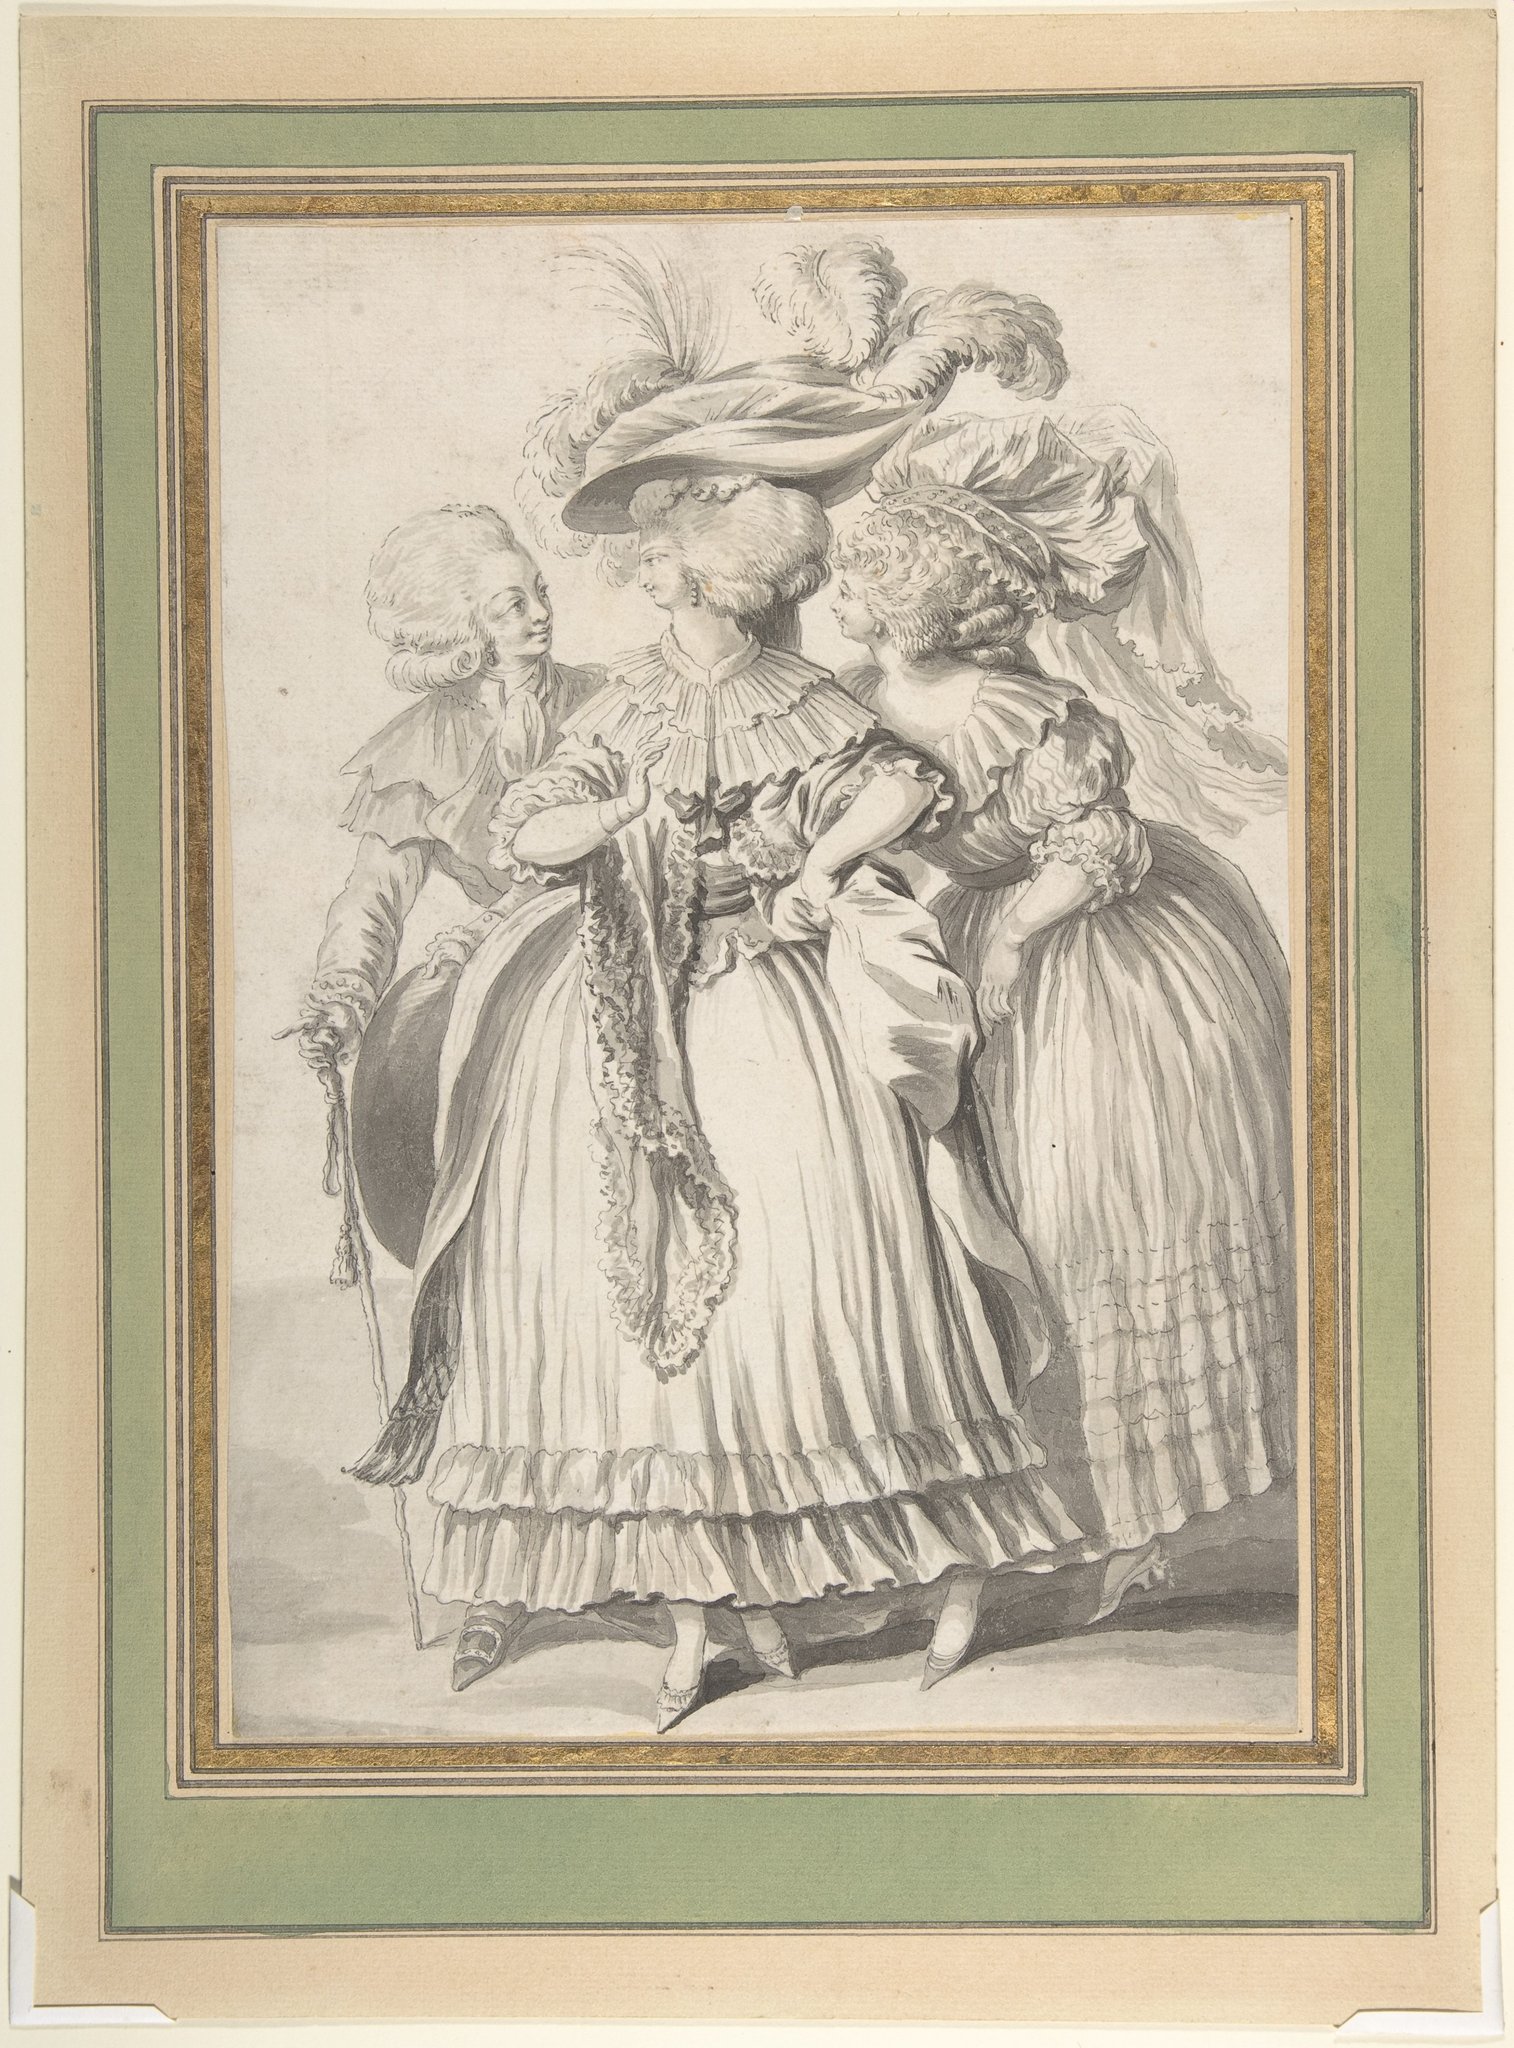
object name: drawing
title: Two Ladies and a Gentleman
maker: louis binet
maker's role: artist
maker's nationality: french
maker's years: 1744-1800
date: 1760-1800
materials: graphite, ink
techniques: brush, pen, wash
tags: men,women